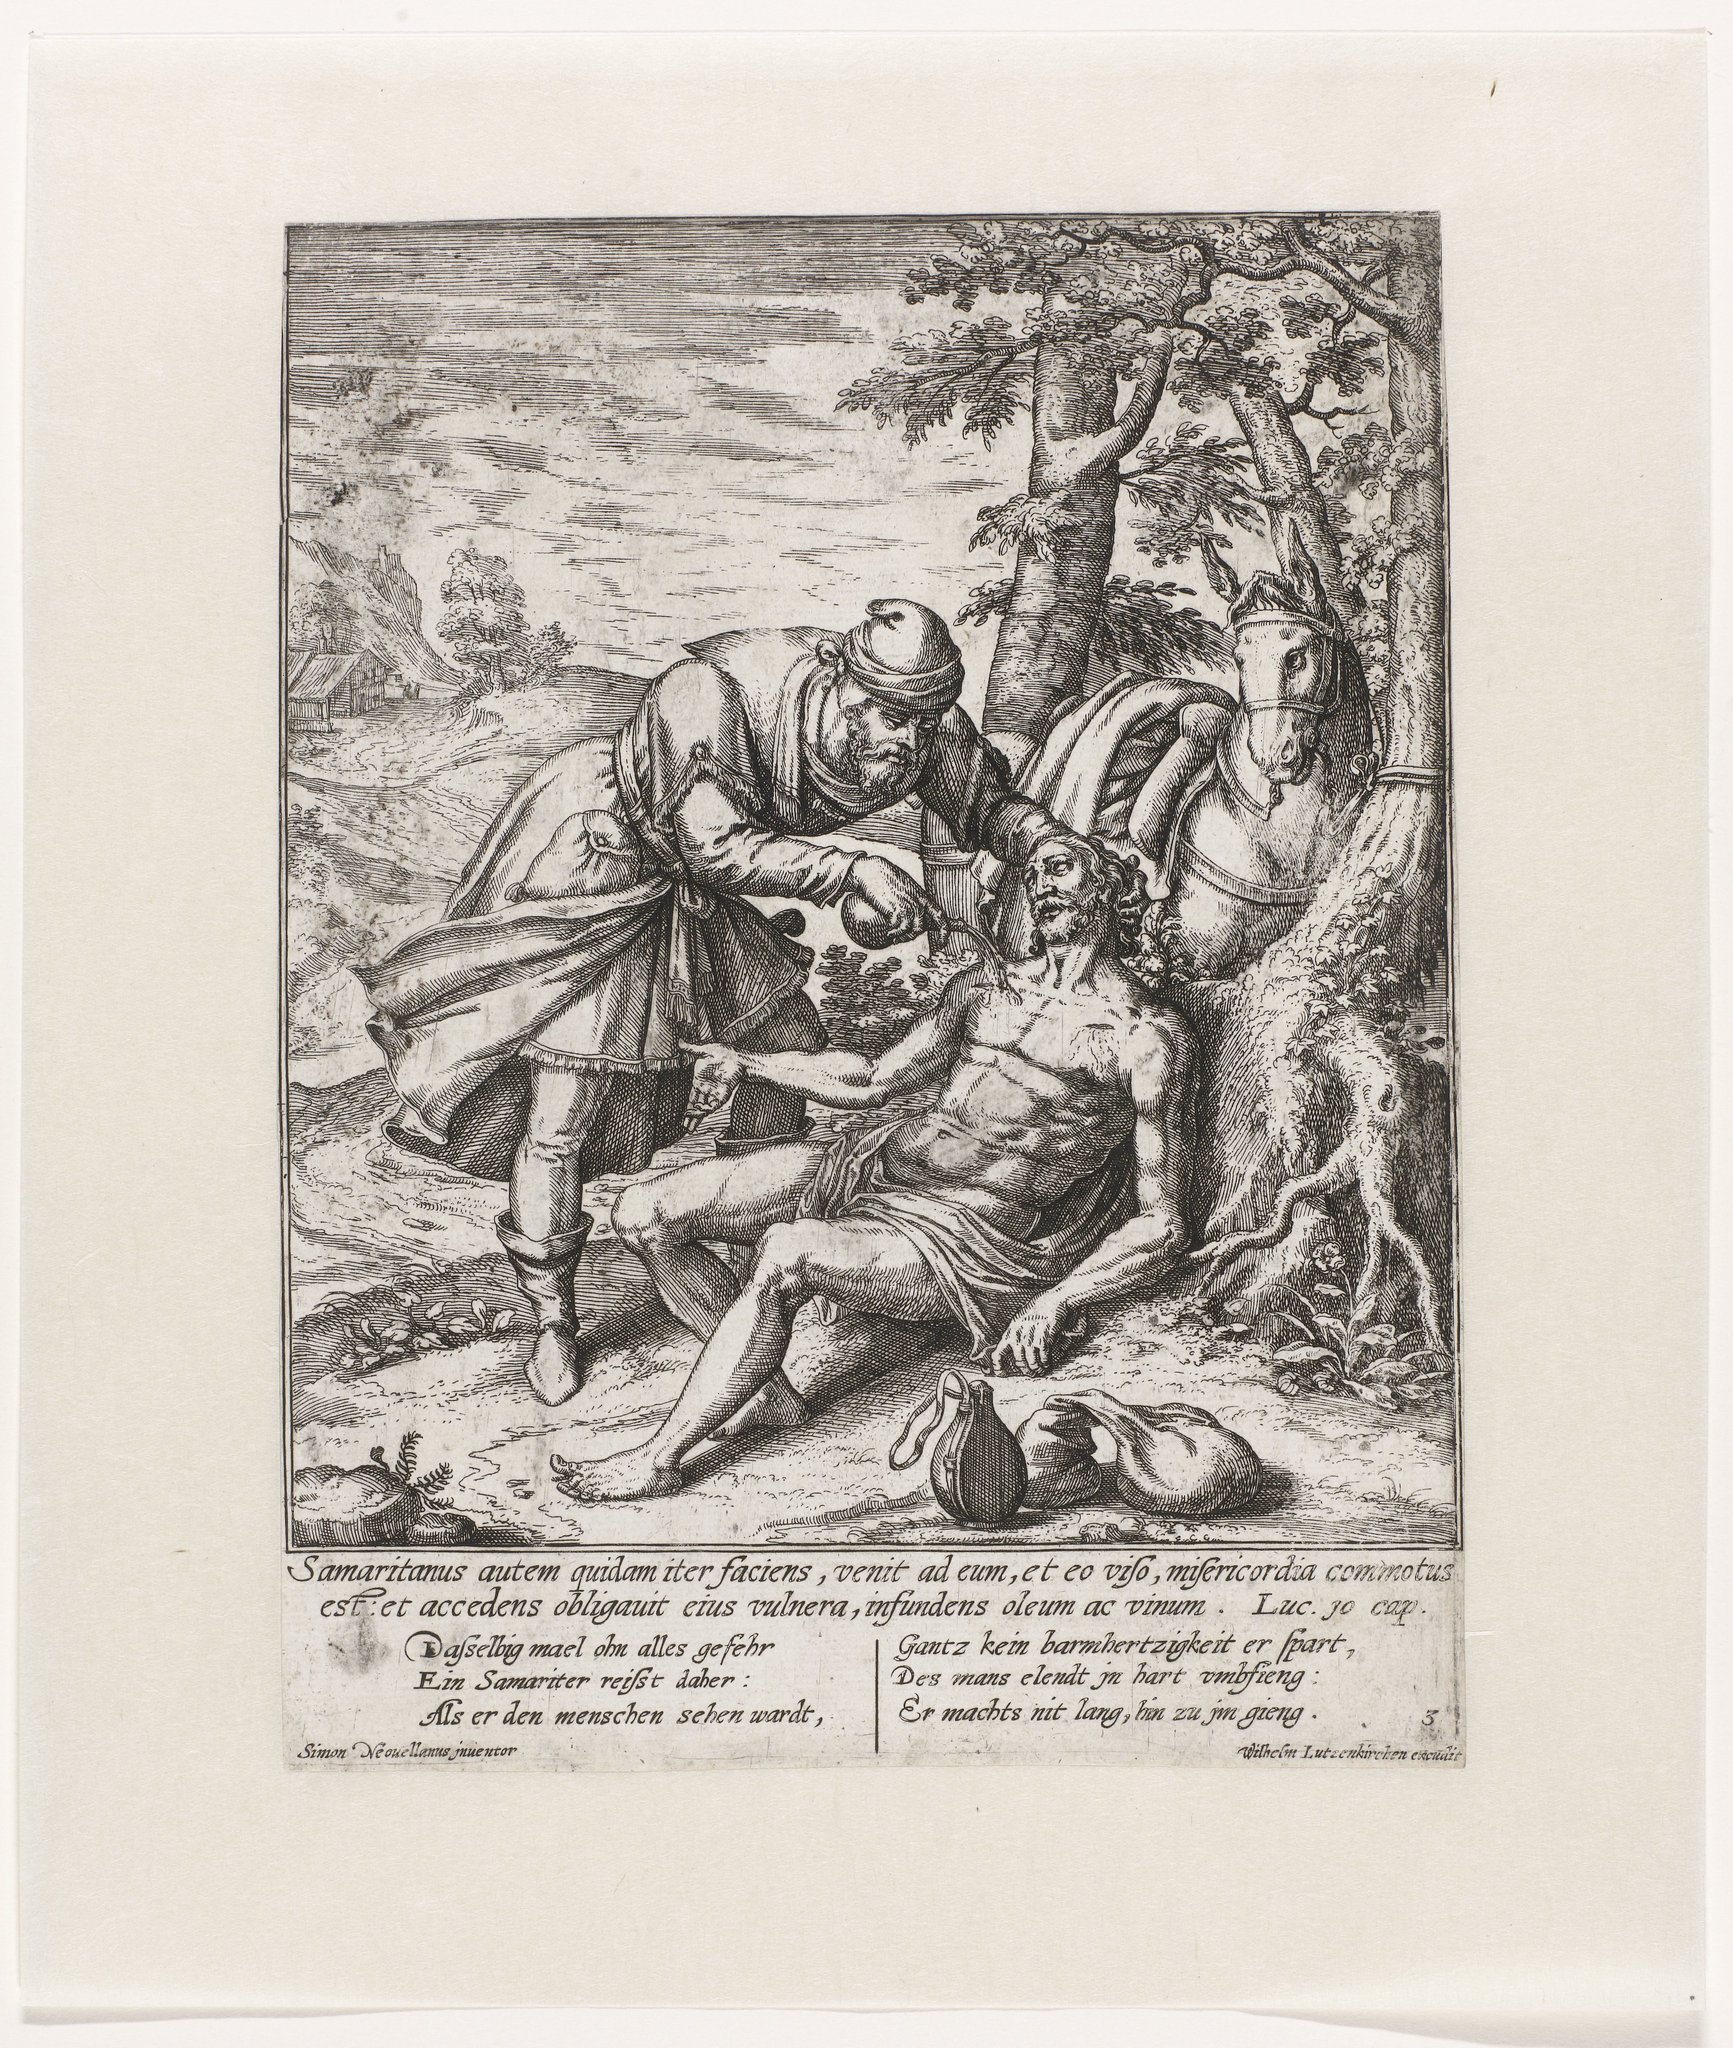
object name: print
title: De barmhartige Samaritaan verzorgt de wonden van de overvallen reiziger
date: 1560-1590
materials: paper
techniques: etching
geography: cologne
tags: ass, donkey, a samaritan tending the wounds of the traveller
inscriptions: collector's mark: Lugt 2760, collector's mark: Lugt 2228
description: De barmhartige Samaritaan giet olie uit een fles op de wond in de schouder van de reiziger, terwijl hij met zijn andere hand diens hoofd ondersteunt. Achter hen de ezel, op de voorgrond nog een fles en een pak. Onder de afbeelding een tweeregelige tekst in het Latijn uit Luc. 10 en een zesregelig vers in het Duits.